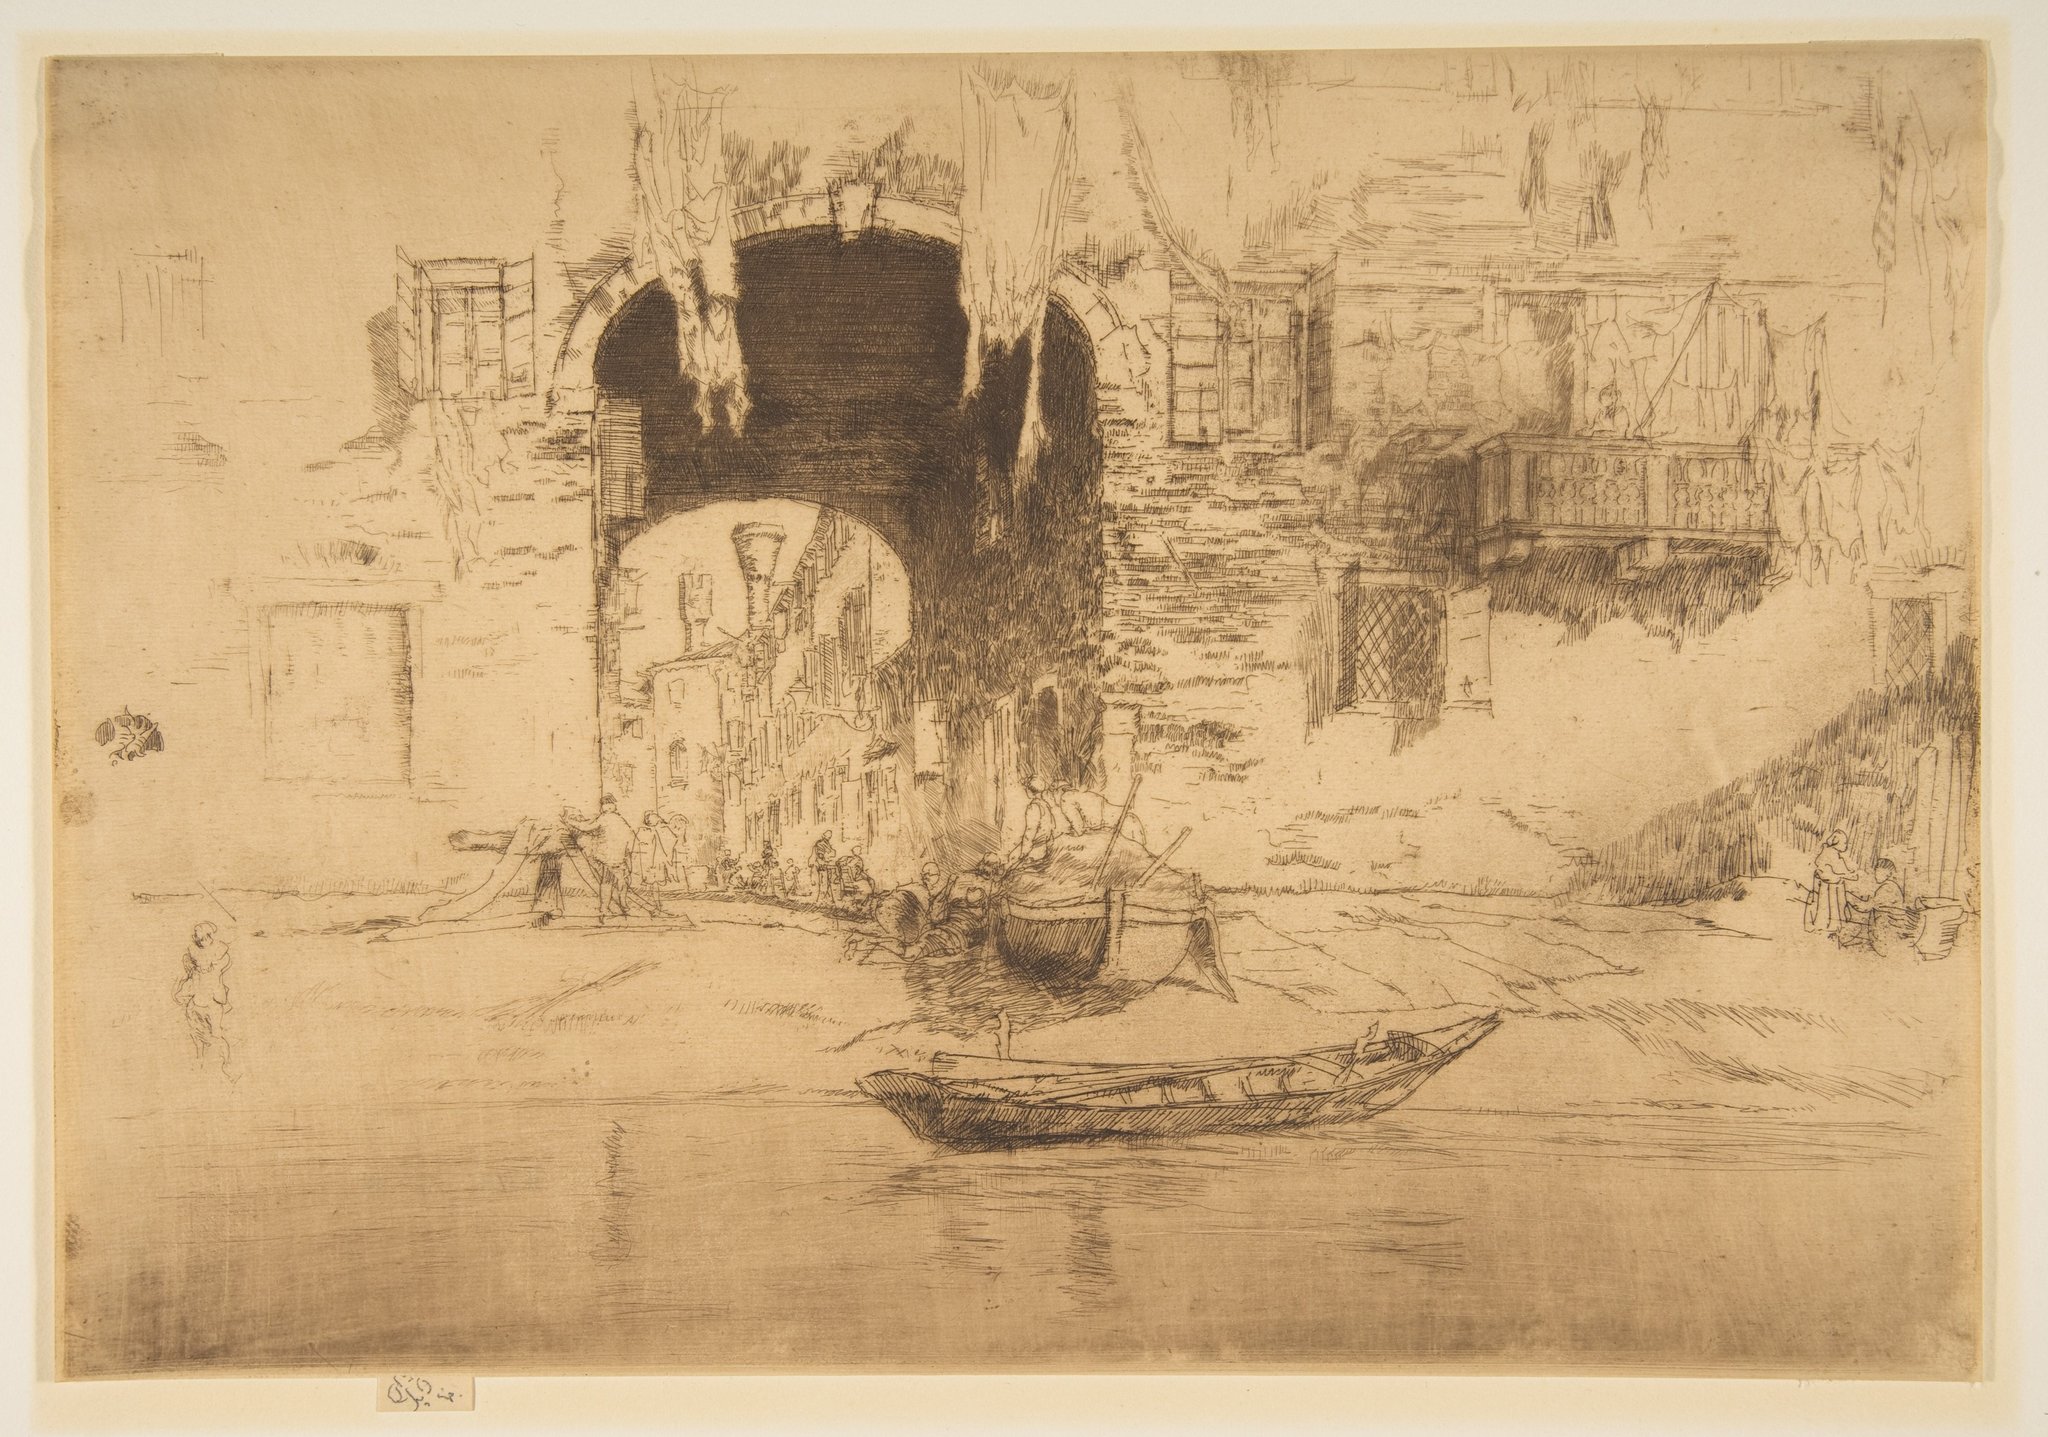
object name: print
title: San Biagio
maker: james mcneill whistler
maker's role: artist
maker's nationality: american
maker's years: 1834-1903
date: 1879-1880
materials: ink, paper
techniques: drypoint, etching, printing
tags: canals,boats,venice